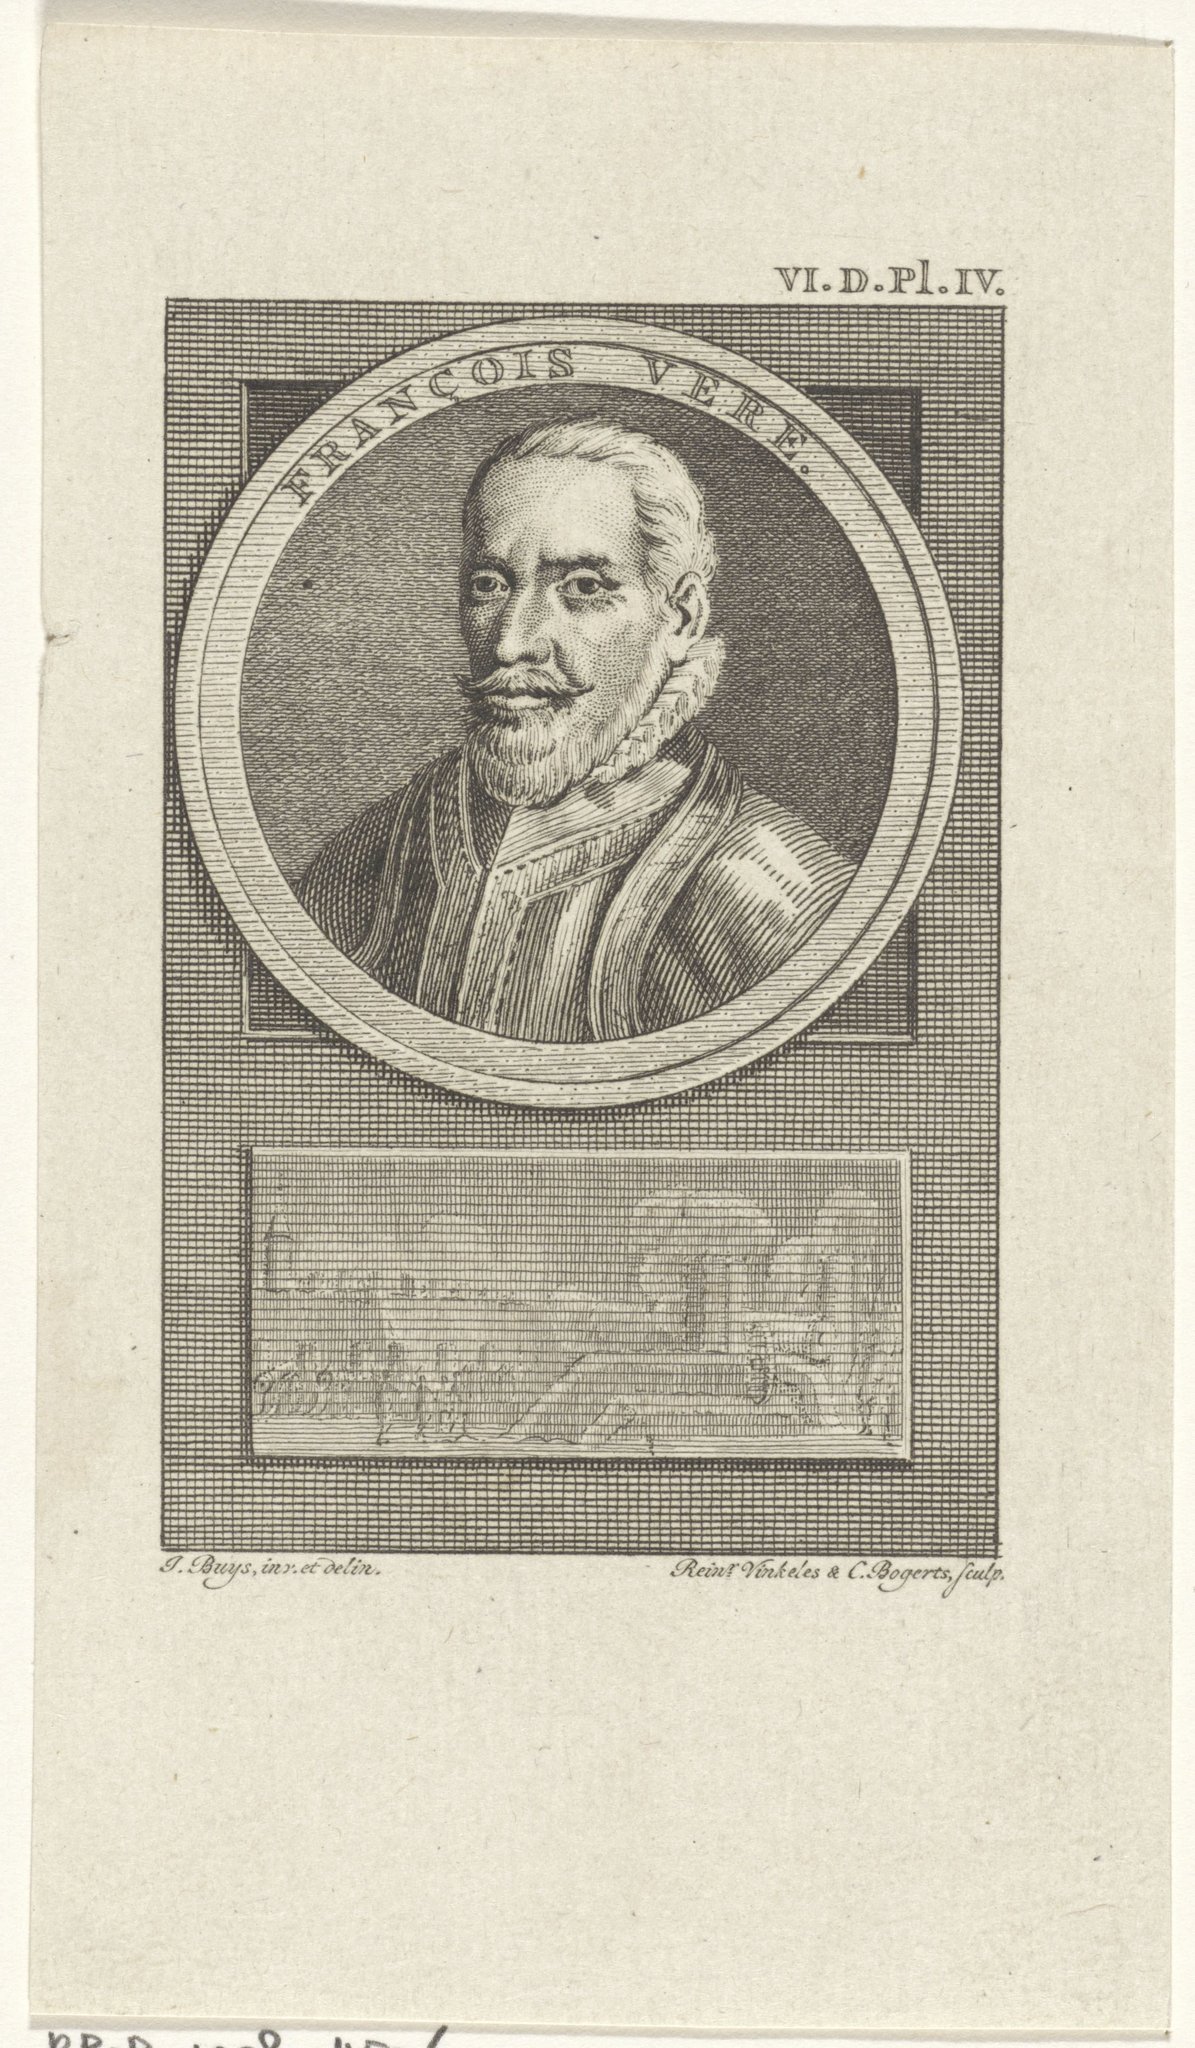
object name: book illustration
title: Portret van Francis Vere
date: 1783-1795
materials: paper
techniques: engraving, etching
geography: amsterdam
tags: legeraanvoerder, francis vere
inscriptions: collector's mark: Lugt 2228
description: Prent gebruikt in: Fokke, Jan. Geschiedenissen der Vereenigde Nederlanden voor de vaderlandsche jeugd Ie-XXVste deel. Amsterdam: Johannes Allart, 1783-1795. Deel VI.